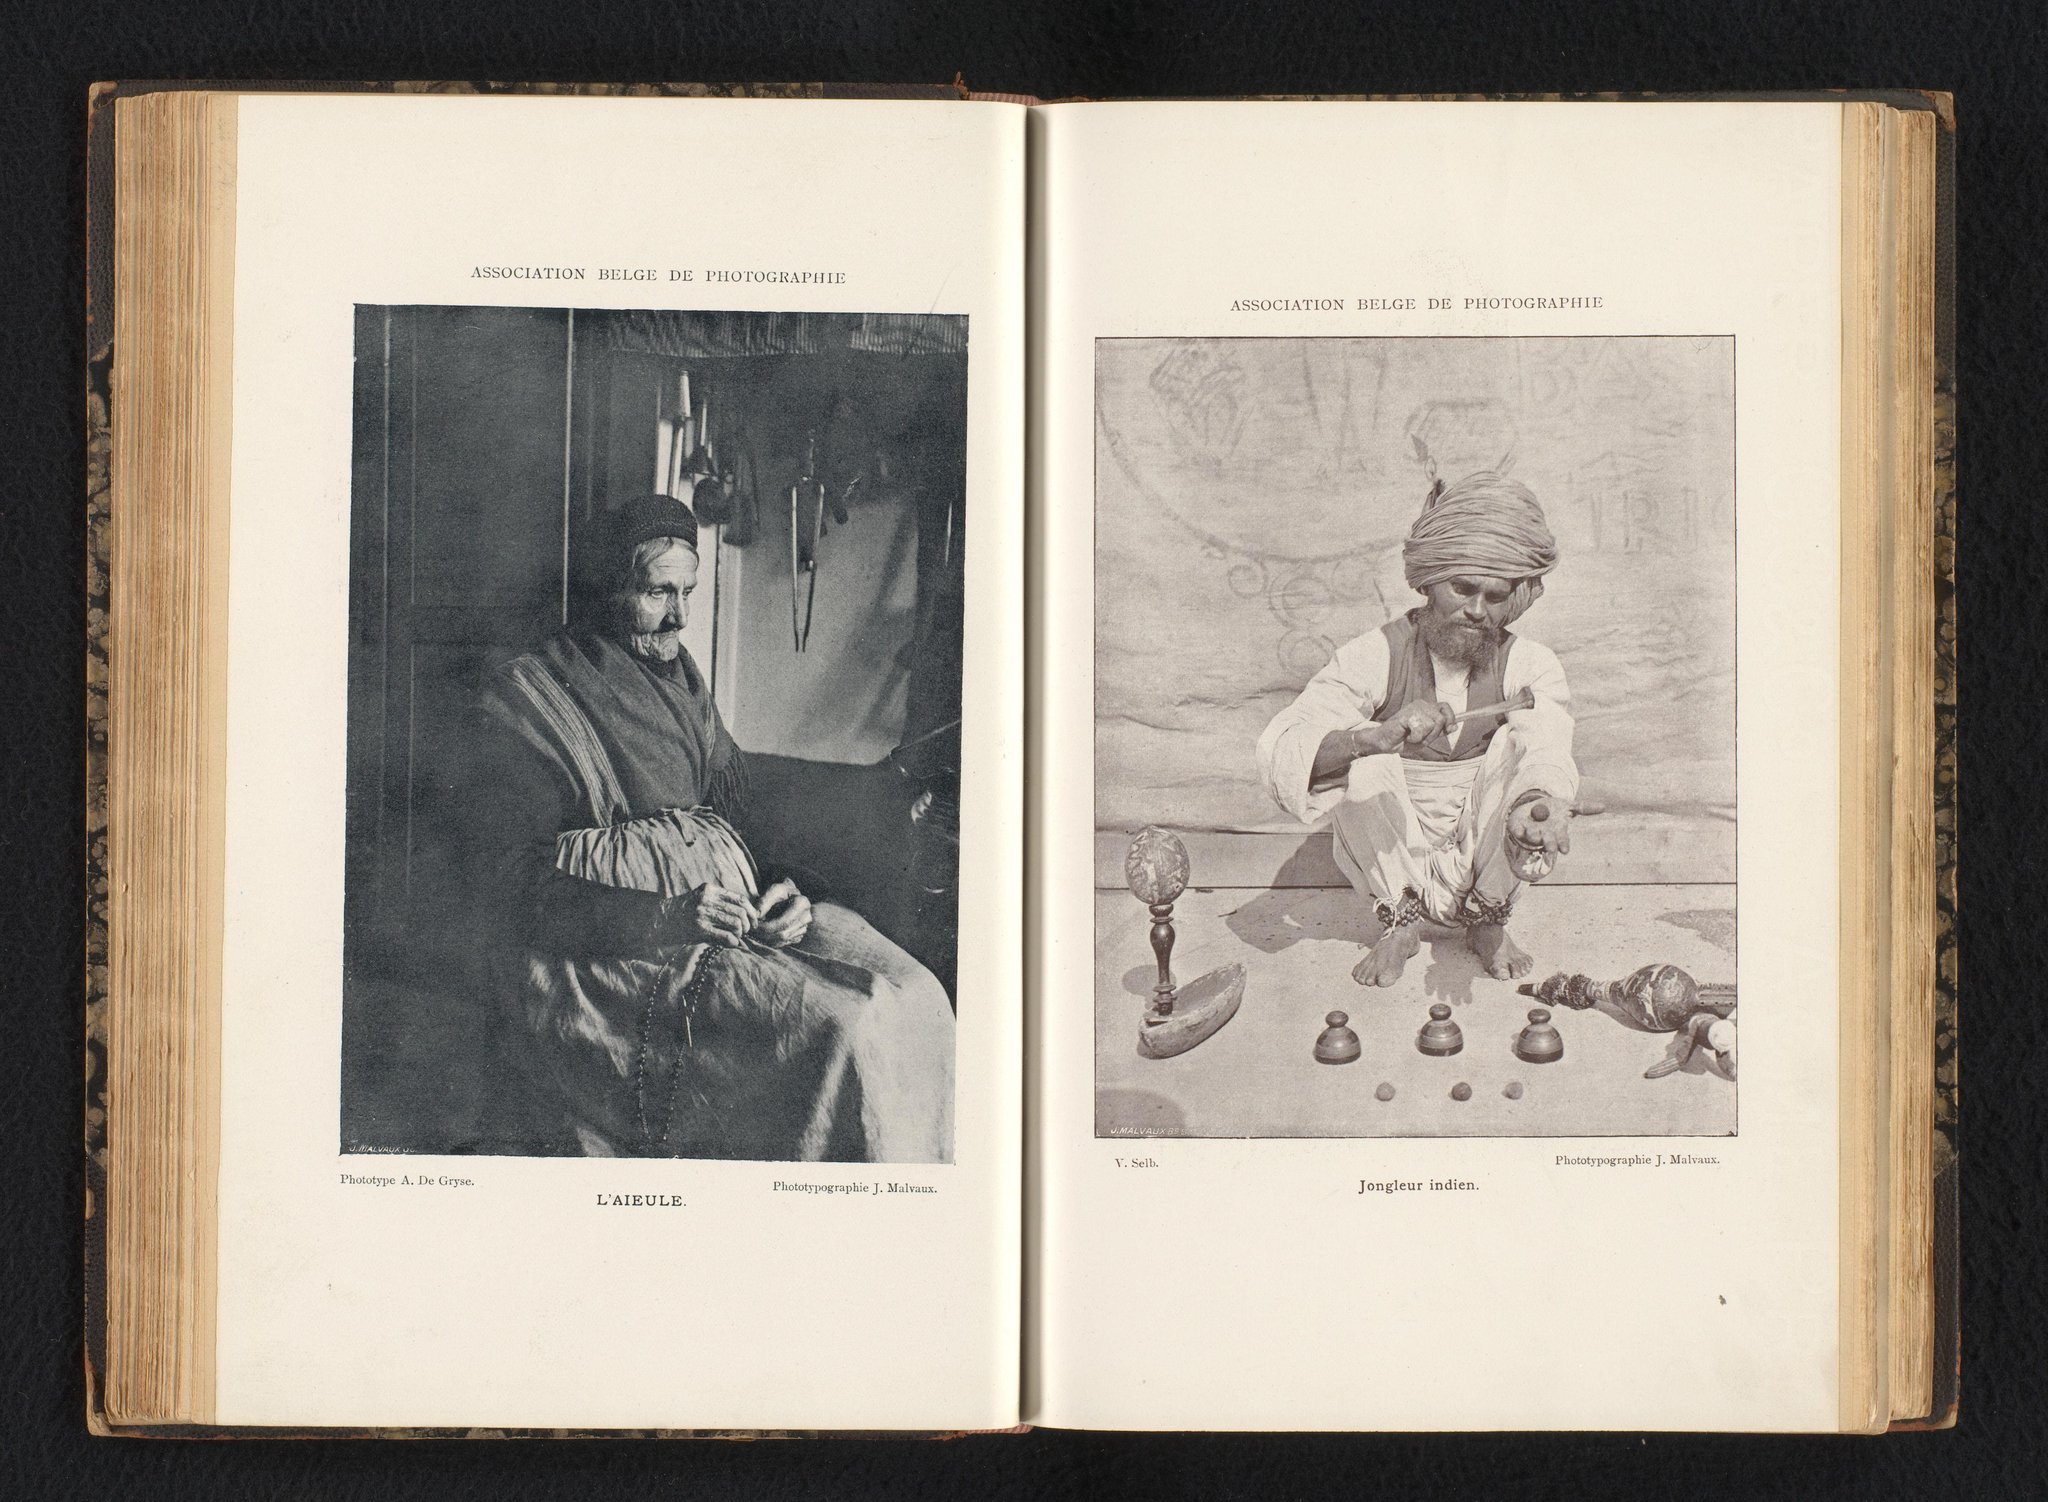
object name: photomechanical print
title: Portret van een onbekende vrouw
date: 1893-1898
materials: paper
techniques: autotype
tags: historical persons, old woman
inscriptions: inscription: ‘Association belge de photographie’